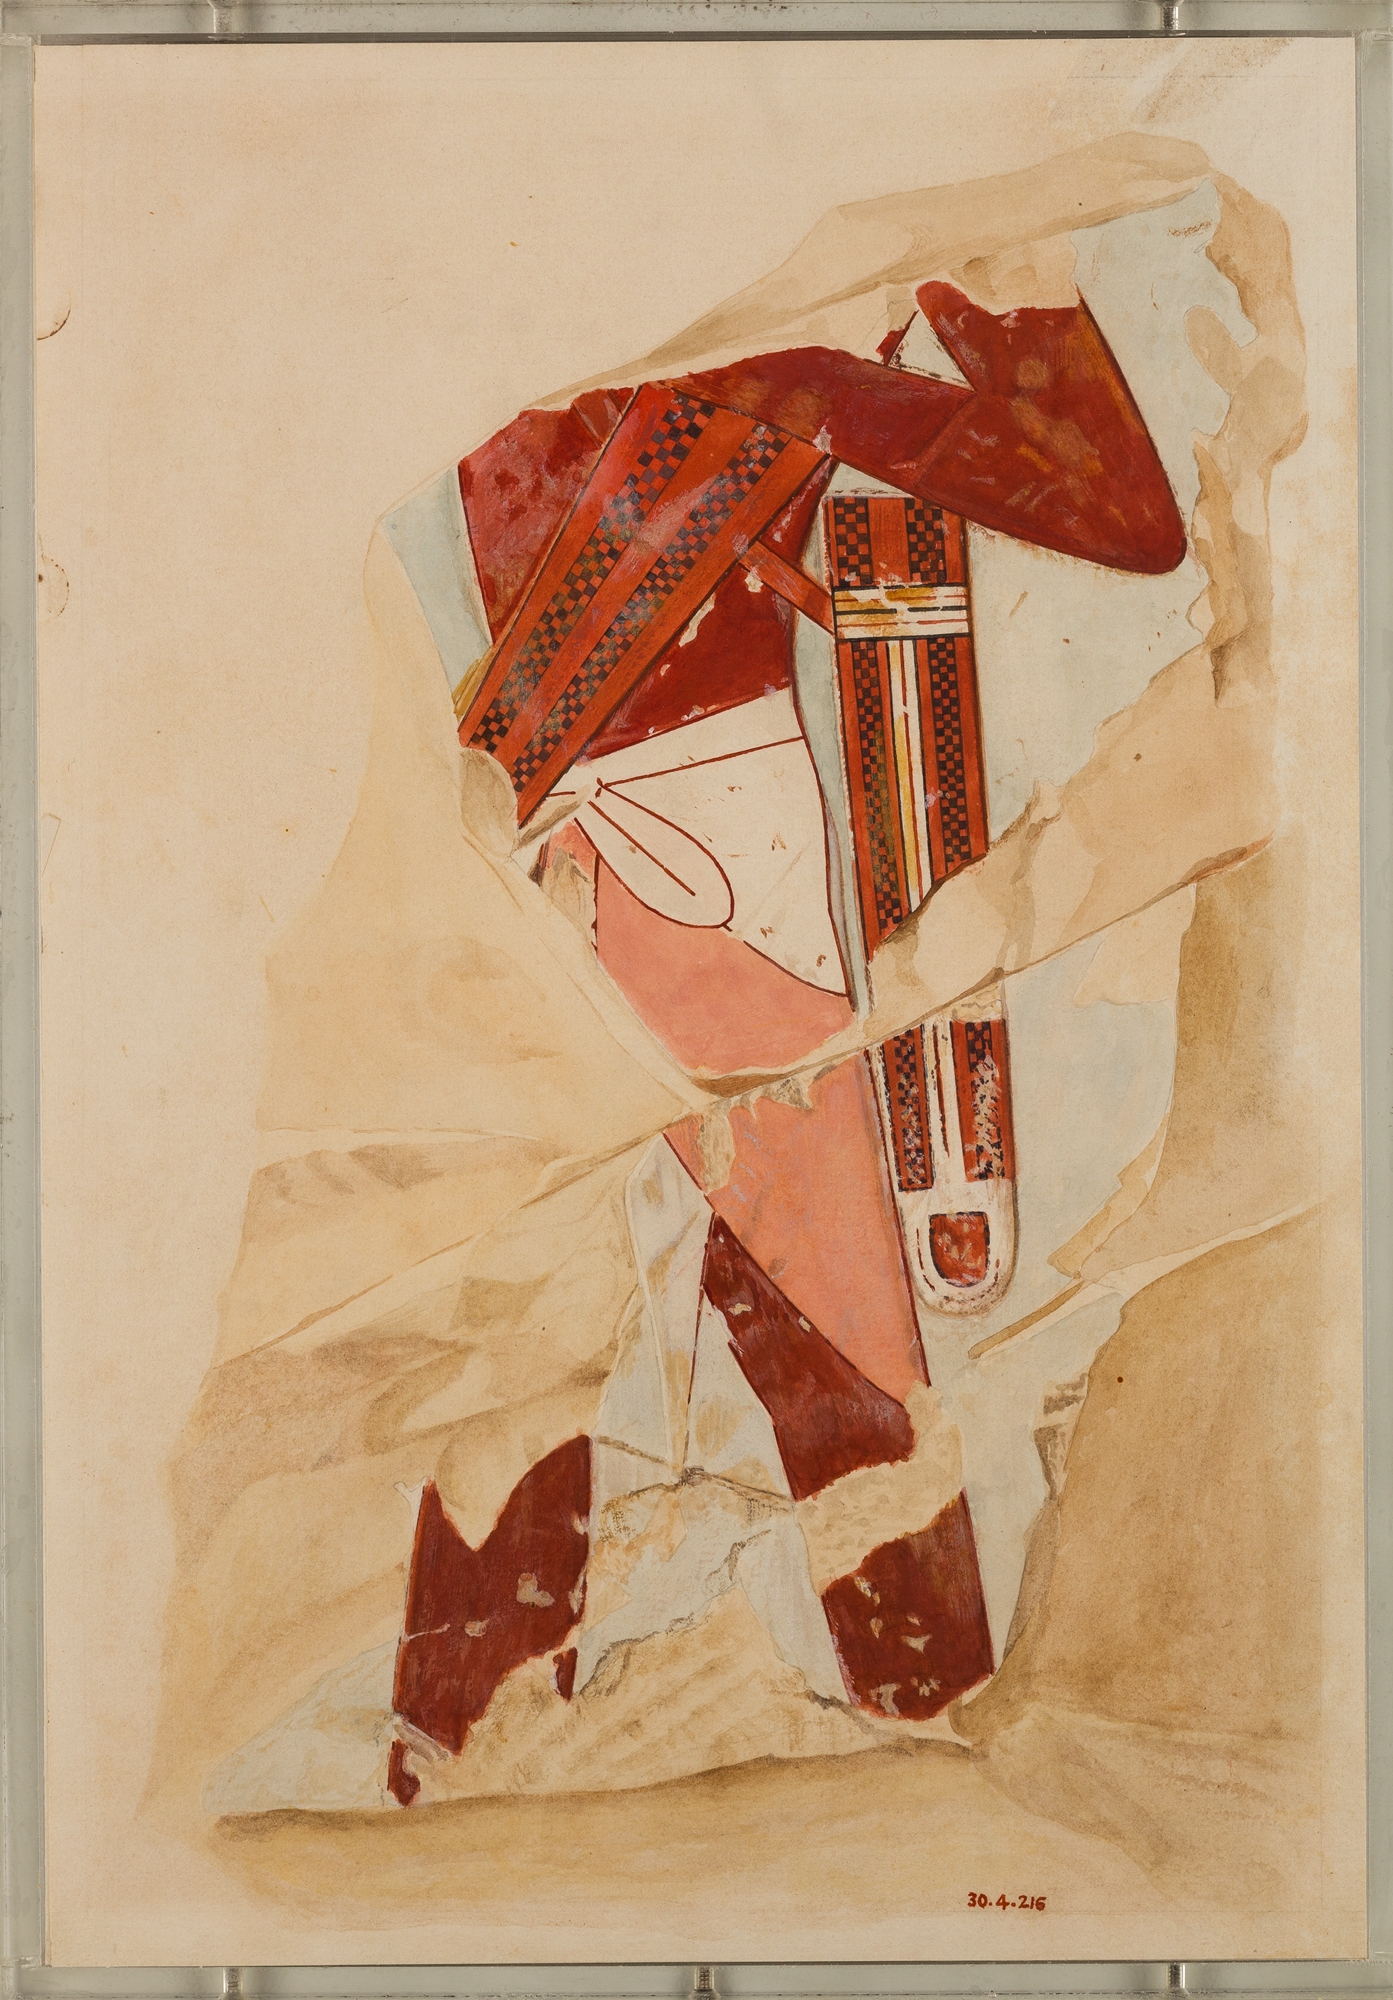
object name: facsimile, puyemre tt 39, weapon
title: Man with a Bow Case and Quiver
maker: hugh r. hopgood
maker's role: artist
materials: paper, paint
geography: egypt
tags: men